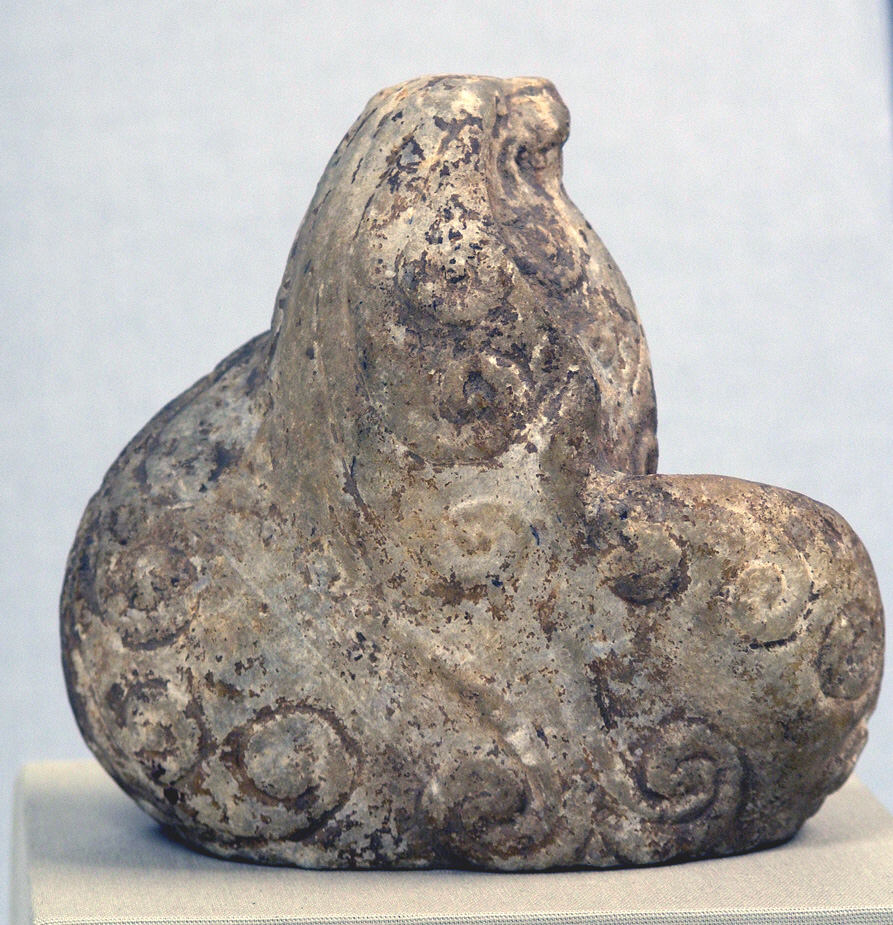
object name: figure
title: Bird with Lion's Head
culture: chinese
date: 618-907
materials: marble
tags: birds